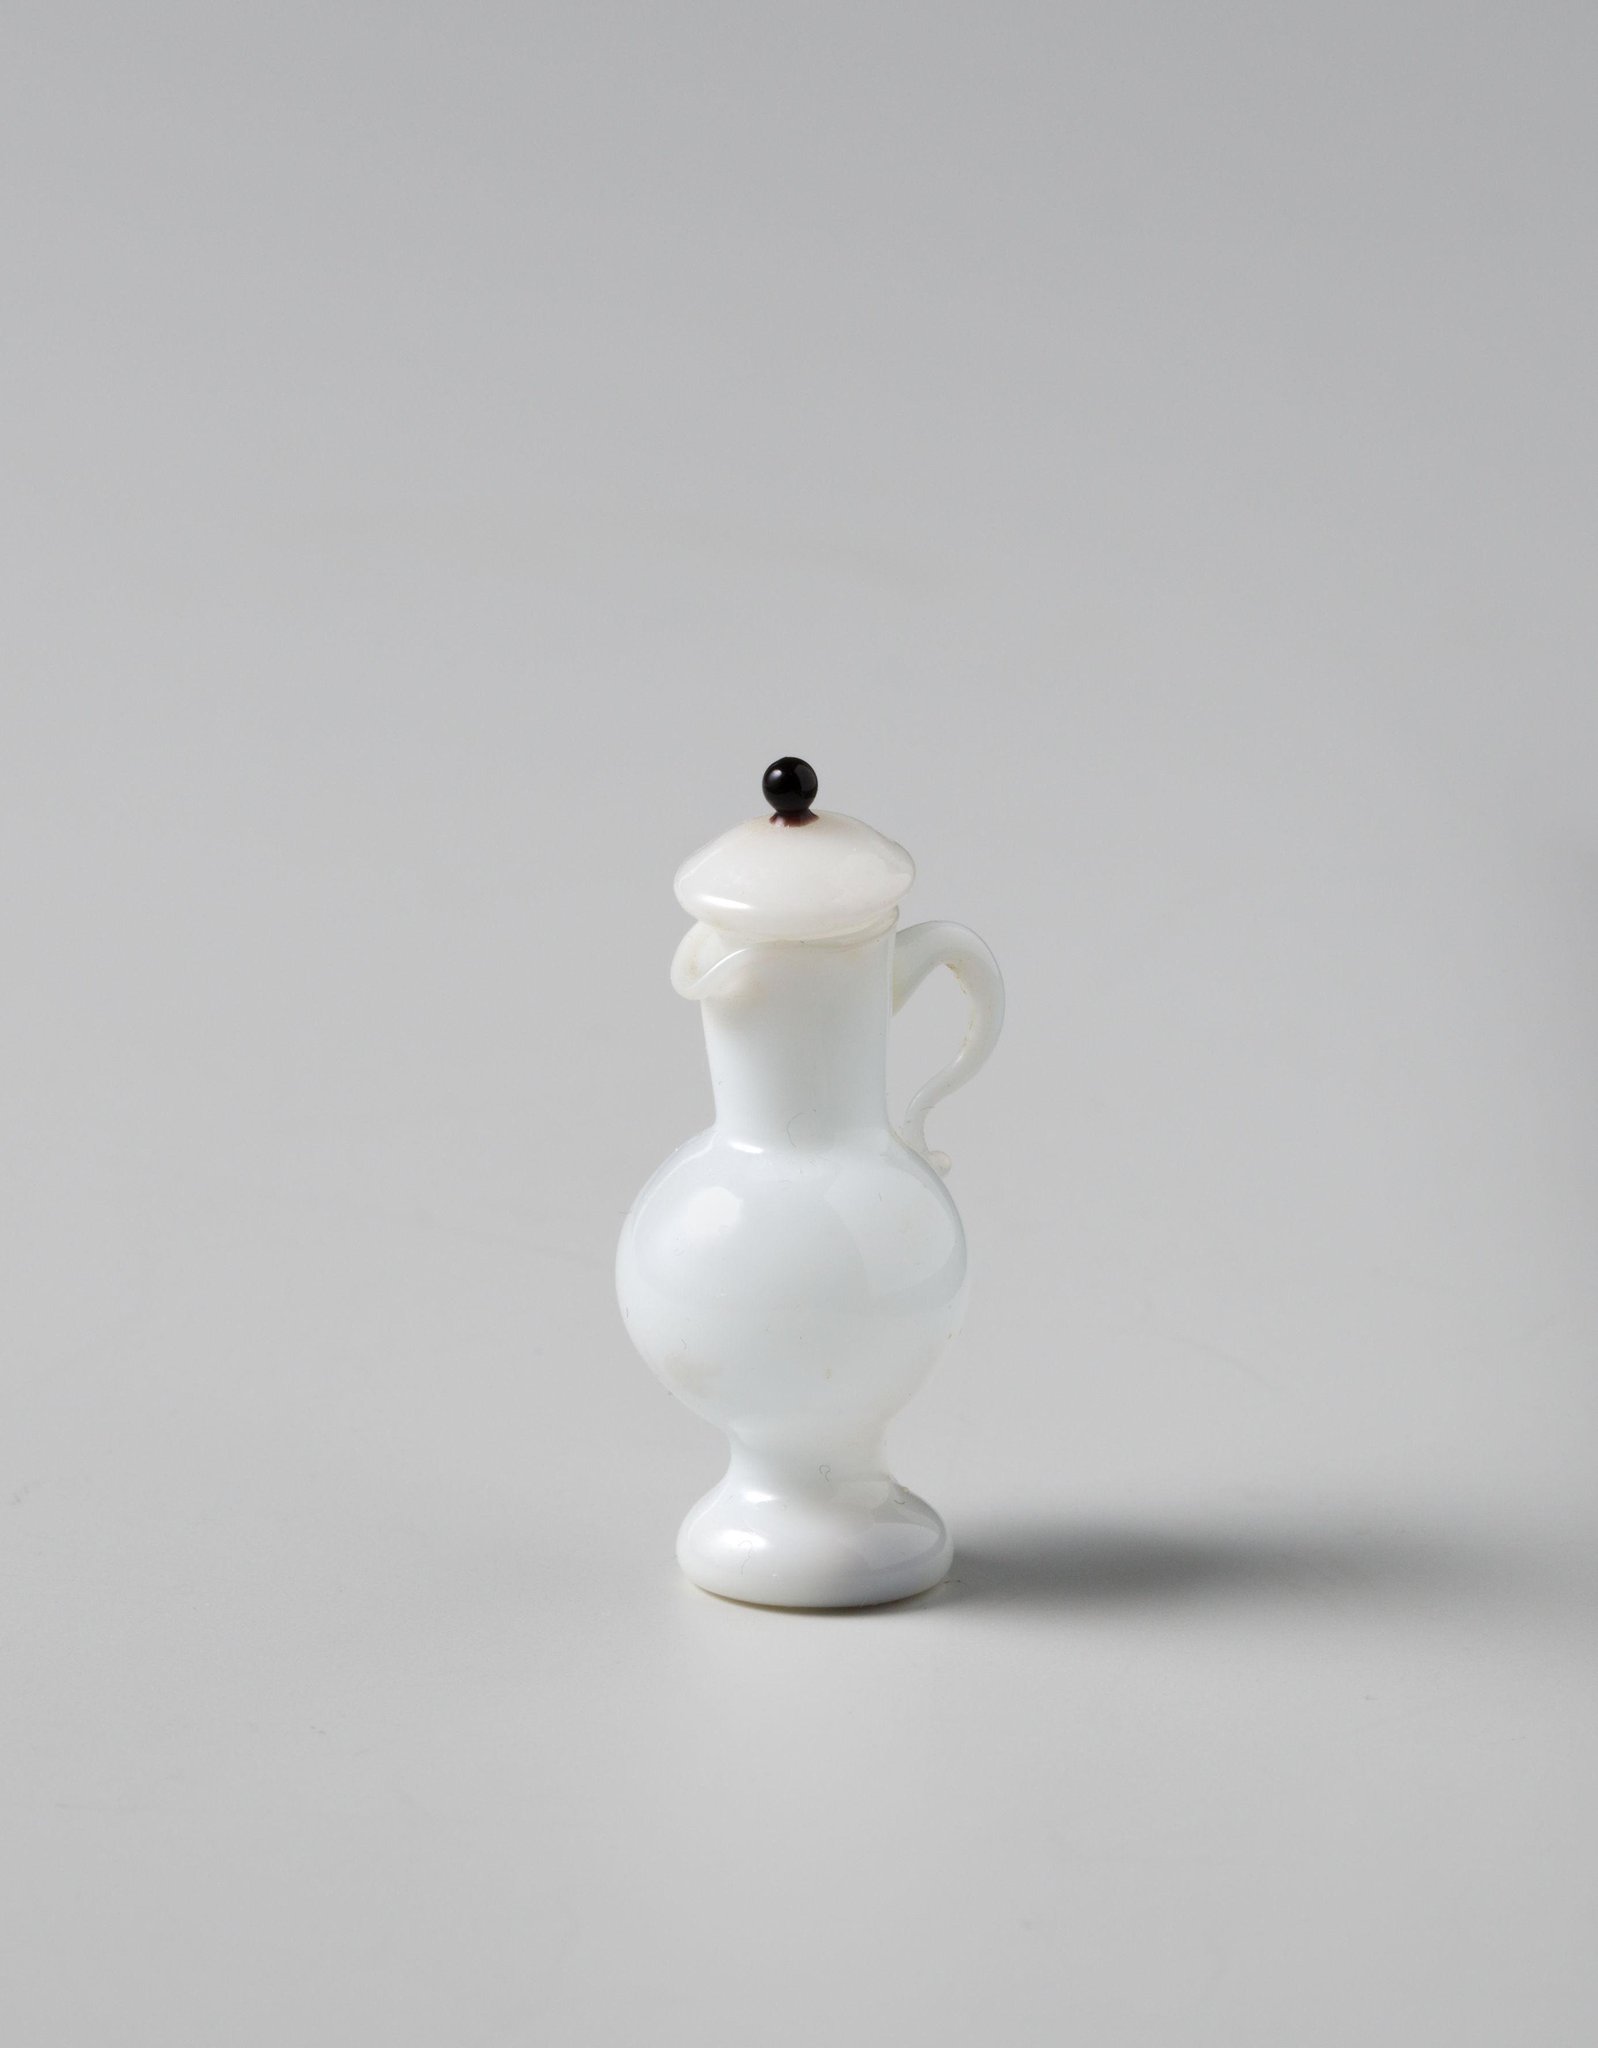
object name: ewer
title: Kan met deksel, beschilderd met bloem in groen en rood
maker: Anonymous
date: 1800-1849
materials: glass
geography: bristol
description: Kan met deksel van opaak wit glas, de bolle buik overgaand in zich iets verbredende voet en brede hals met tuit, met s-vormig oor, conisch oplopende deksel met zwarte knop en rode stippen. De kan bezit geen beschildering meer. De kan behoort tot een set van vijf stuks.